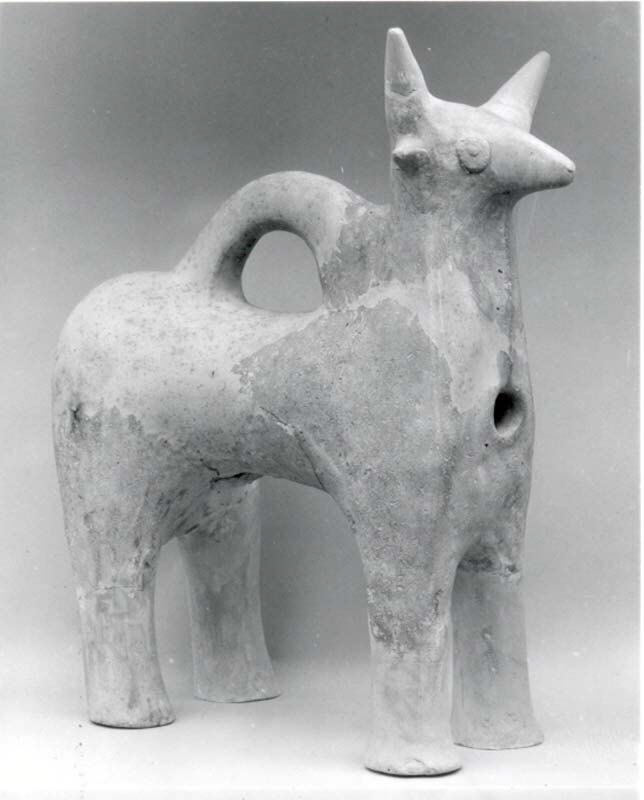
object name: vessel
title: Vessel in form of horned quadruped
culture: iranian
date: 700-550 BCE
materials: ceramic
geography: iran, luristan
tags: animals